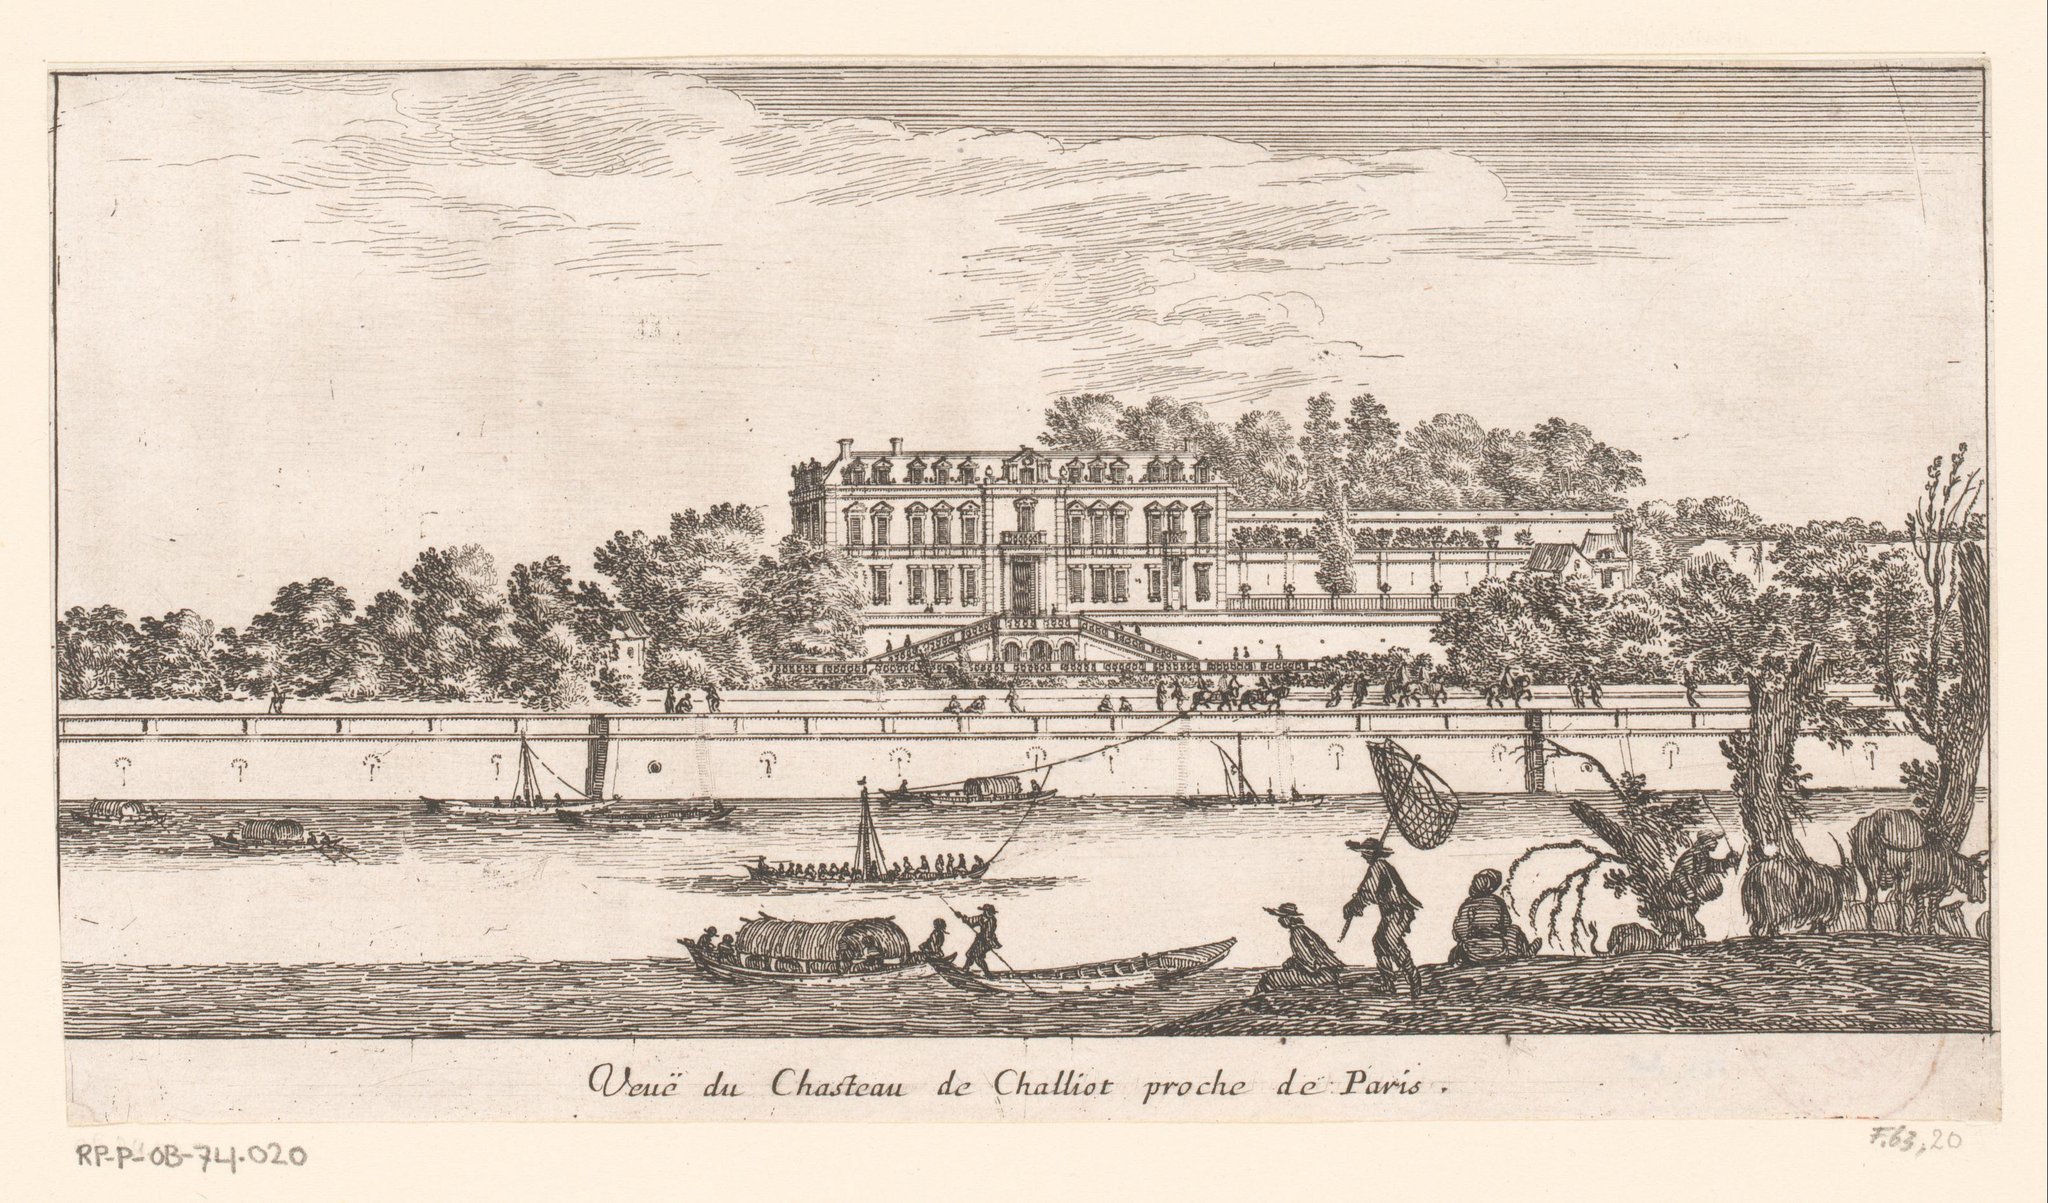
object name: print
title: Hommage aan de rijkdom die de rivieren brengen aan Parijs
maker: israël silvestre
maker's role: draughtsman, print maker, publisher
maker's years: 1621-1691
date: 1654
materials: paper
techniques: engraving, etching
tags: landscape with tower or castle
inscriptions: collector's mark: Lugt 240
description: Prent maakt deel uit van een ongenummerde serie van 21 prenten.